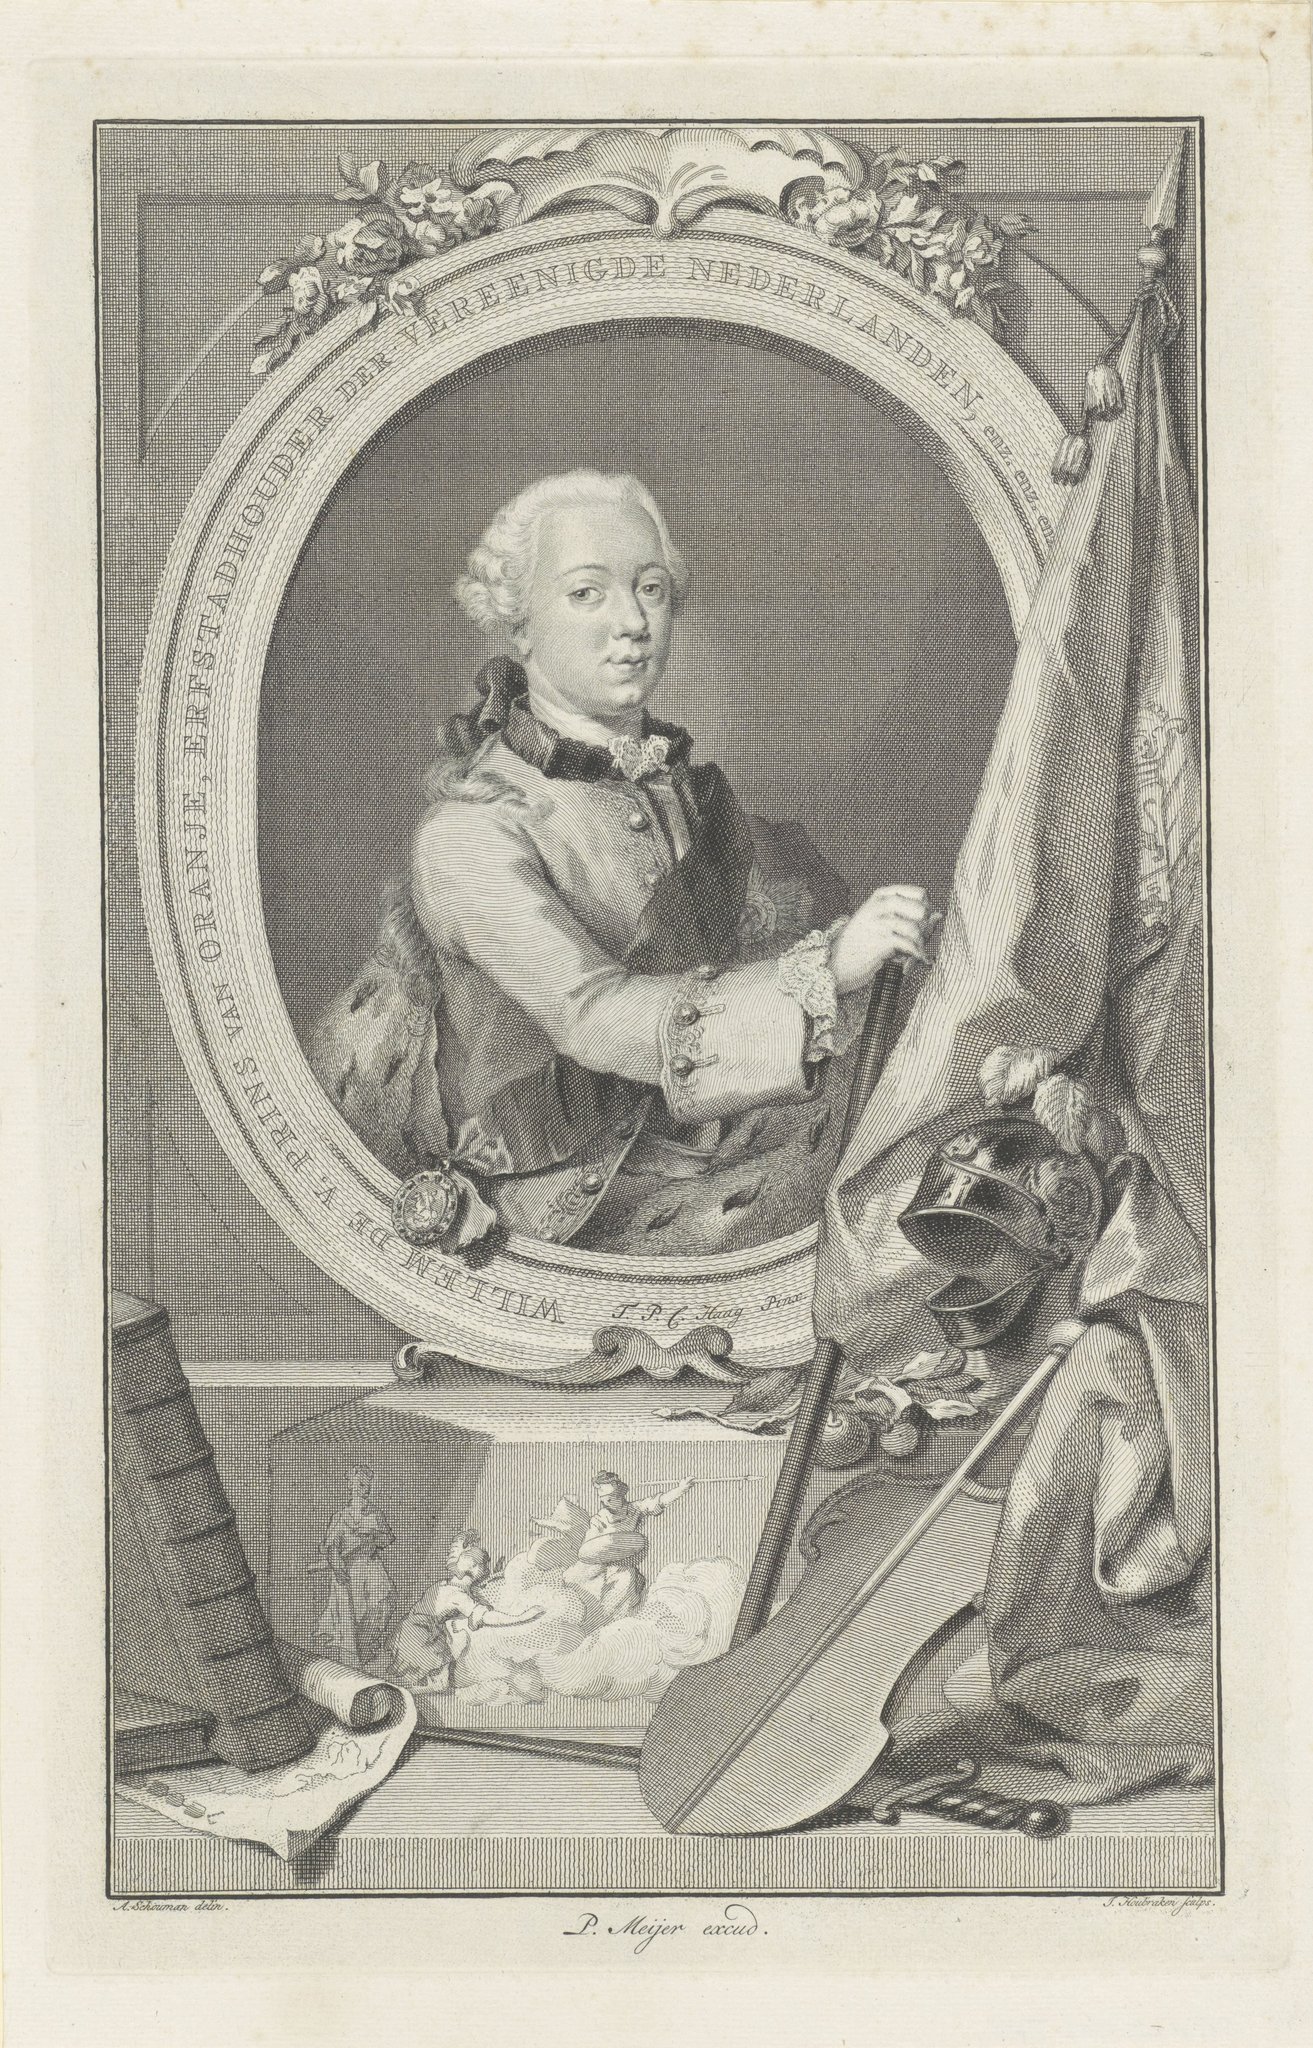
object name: print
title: Portret van Willem V, prins van Oranje-Nassau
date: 1765-1785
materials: paper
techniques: engraving, etching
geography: amsterdam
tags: the hague, william v (prince of orange), knighthood order (garter) - insignia of a knighthood order, e.g.: badge, chain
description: Portret van Willem V in een ovaal met randschrift. Rondom ligt een aantal allegorische objecten, waaronder een helm en een boek. Op het reliëf een allegorische voorstelling.